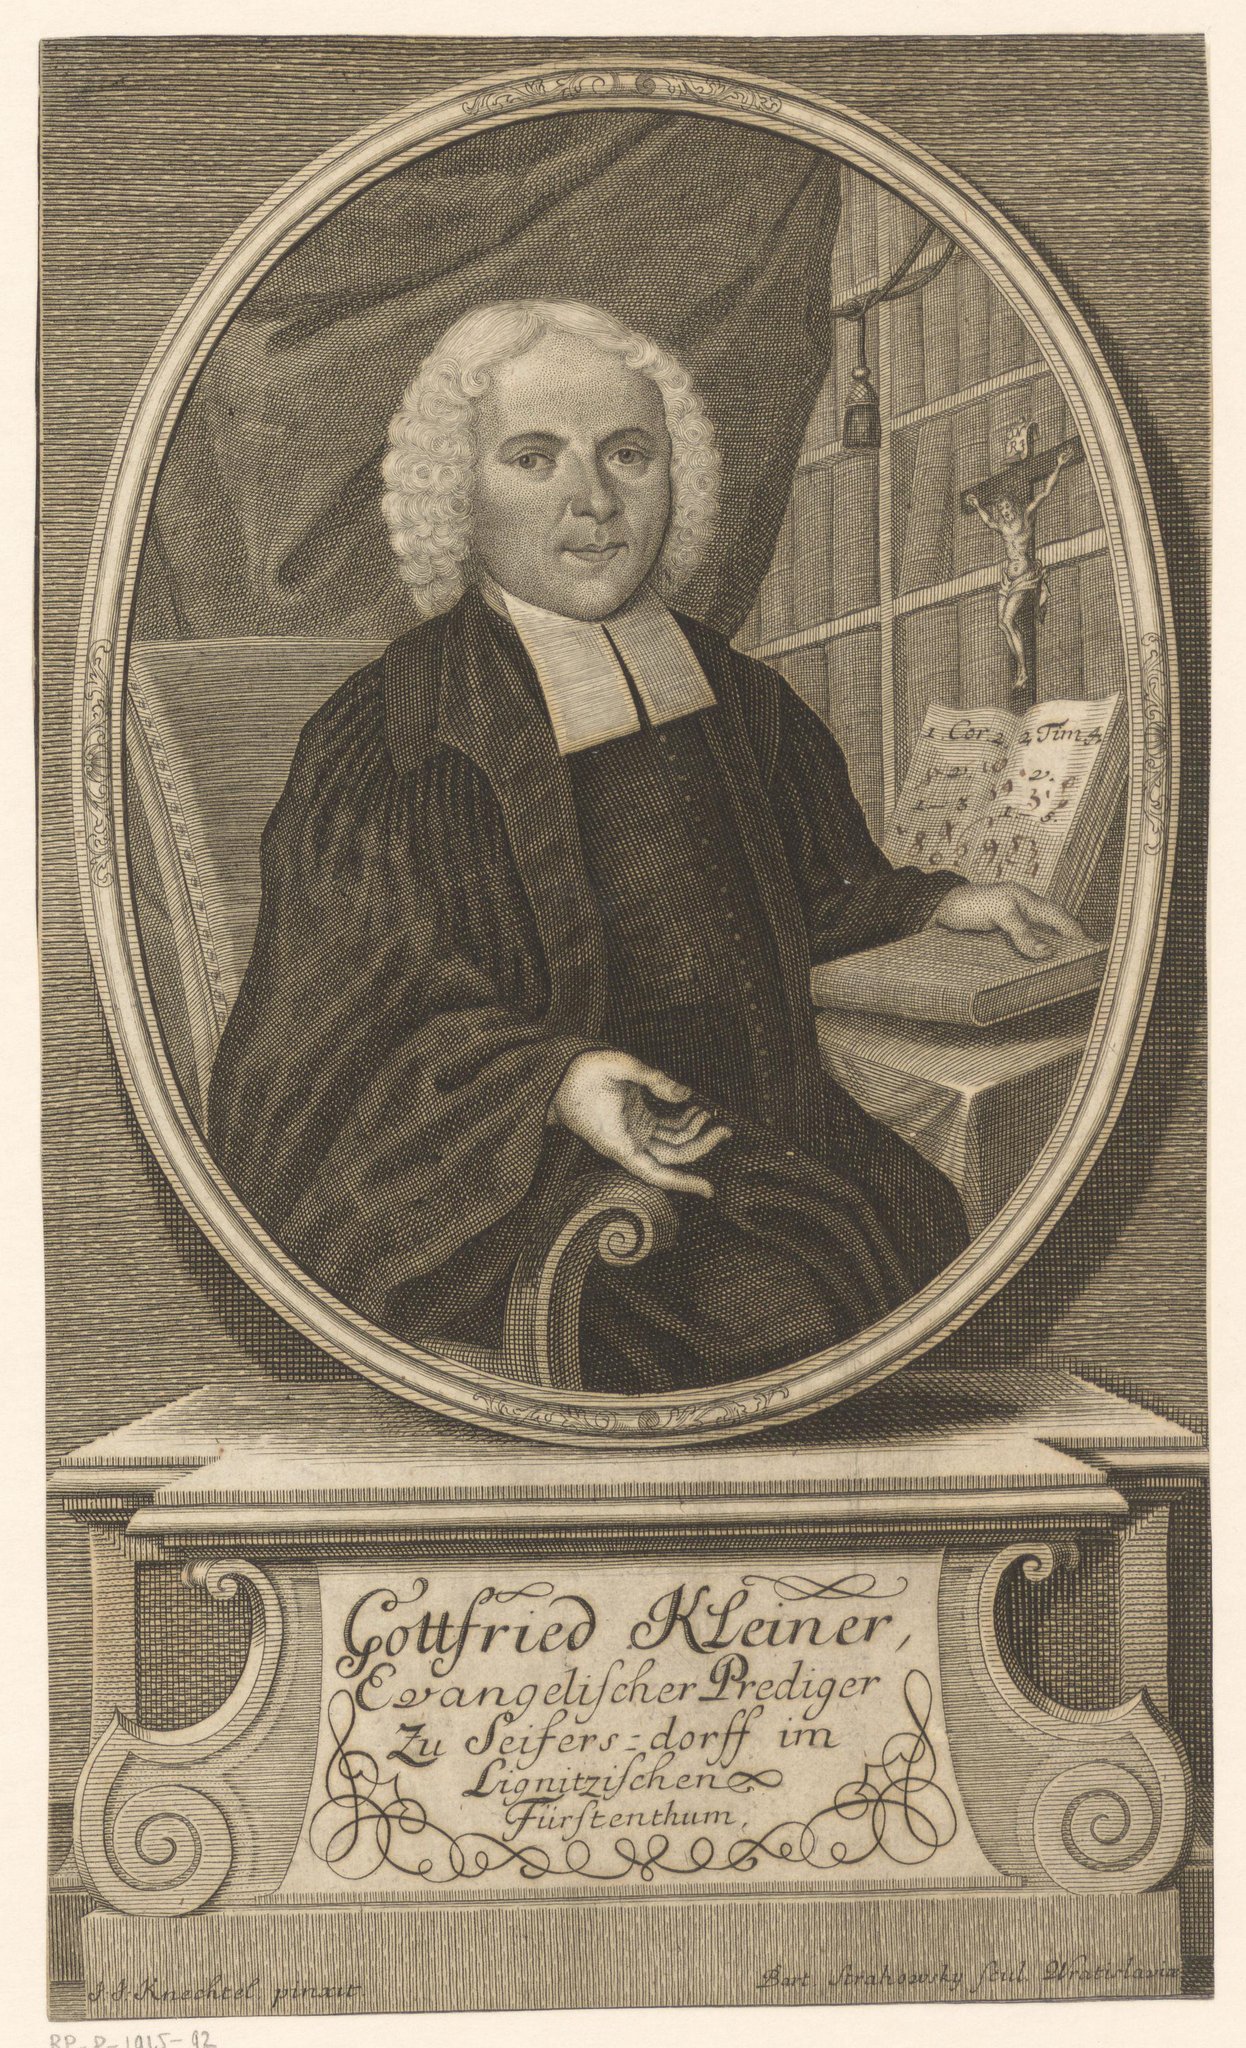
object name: print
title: Portret van Gottfried Kleiner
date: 1712-1759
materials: paper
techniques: engraving, intaglio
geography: breslau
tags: poland, bookshelves, historical persons, book, crucifix ~ personal devotion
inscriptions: collector's mark: Lugt 2228